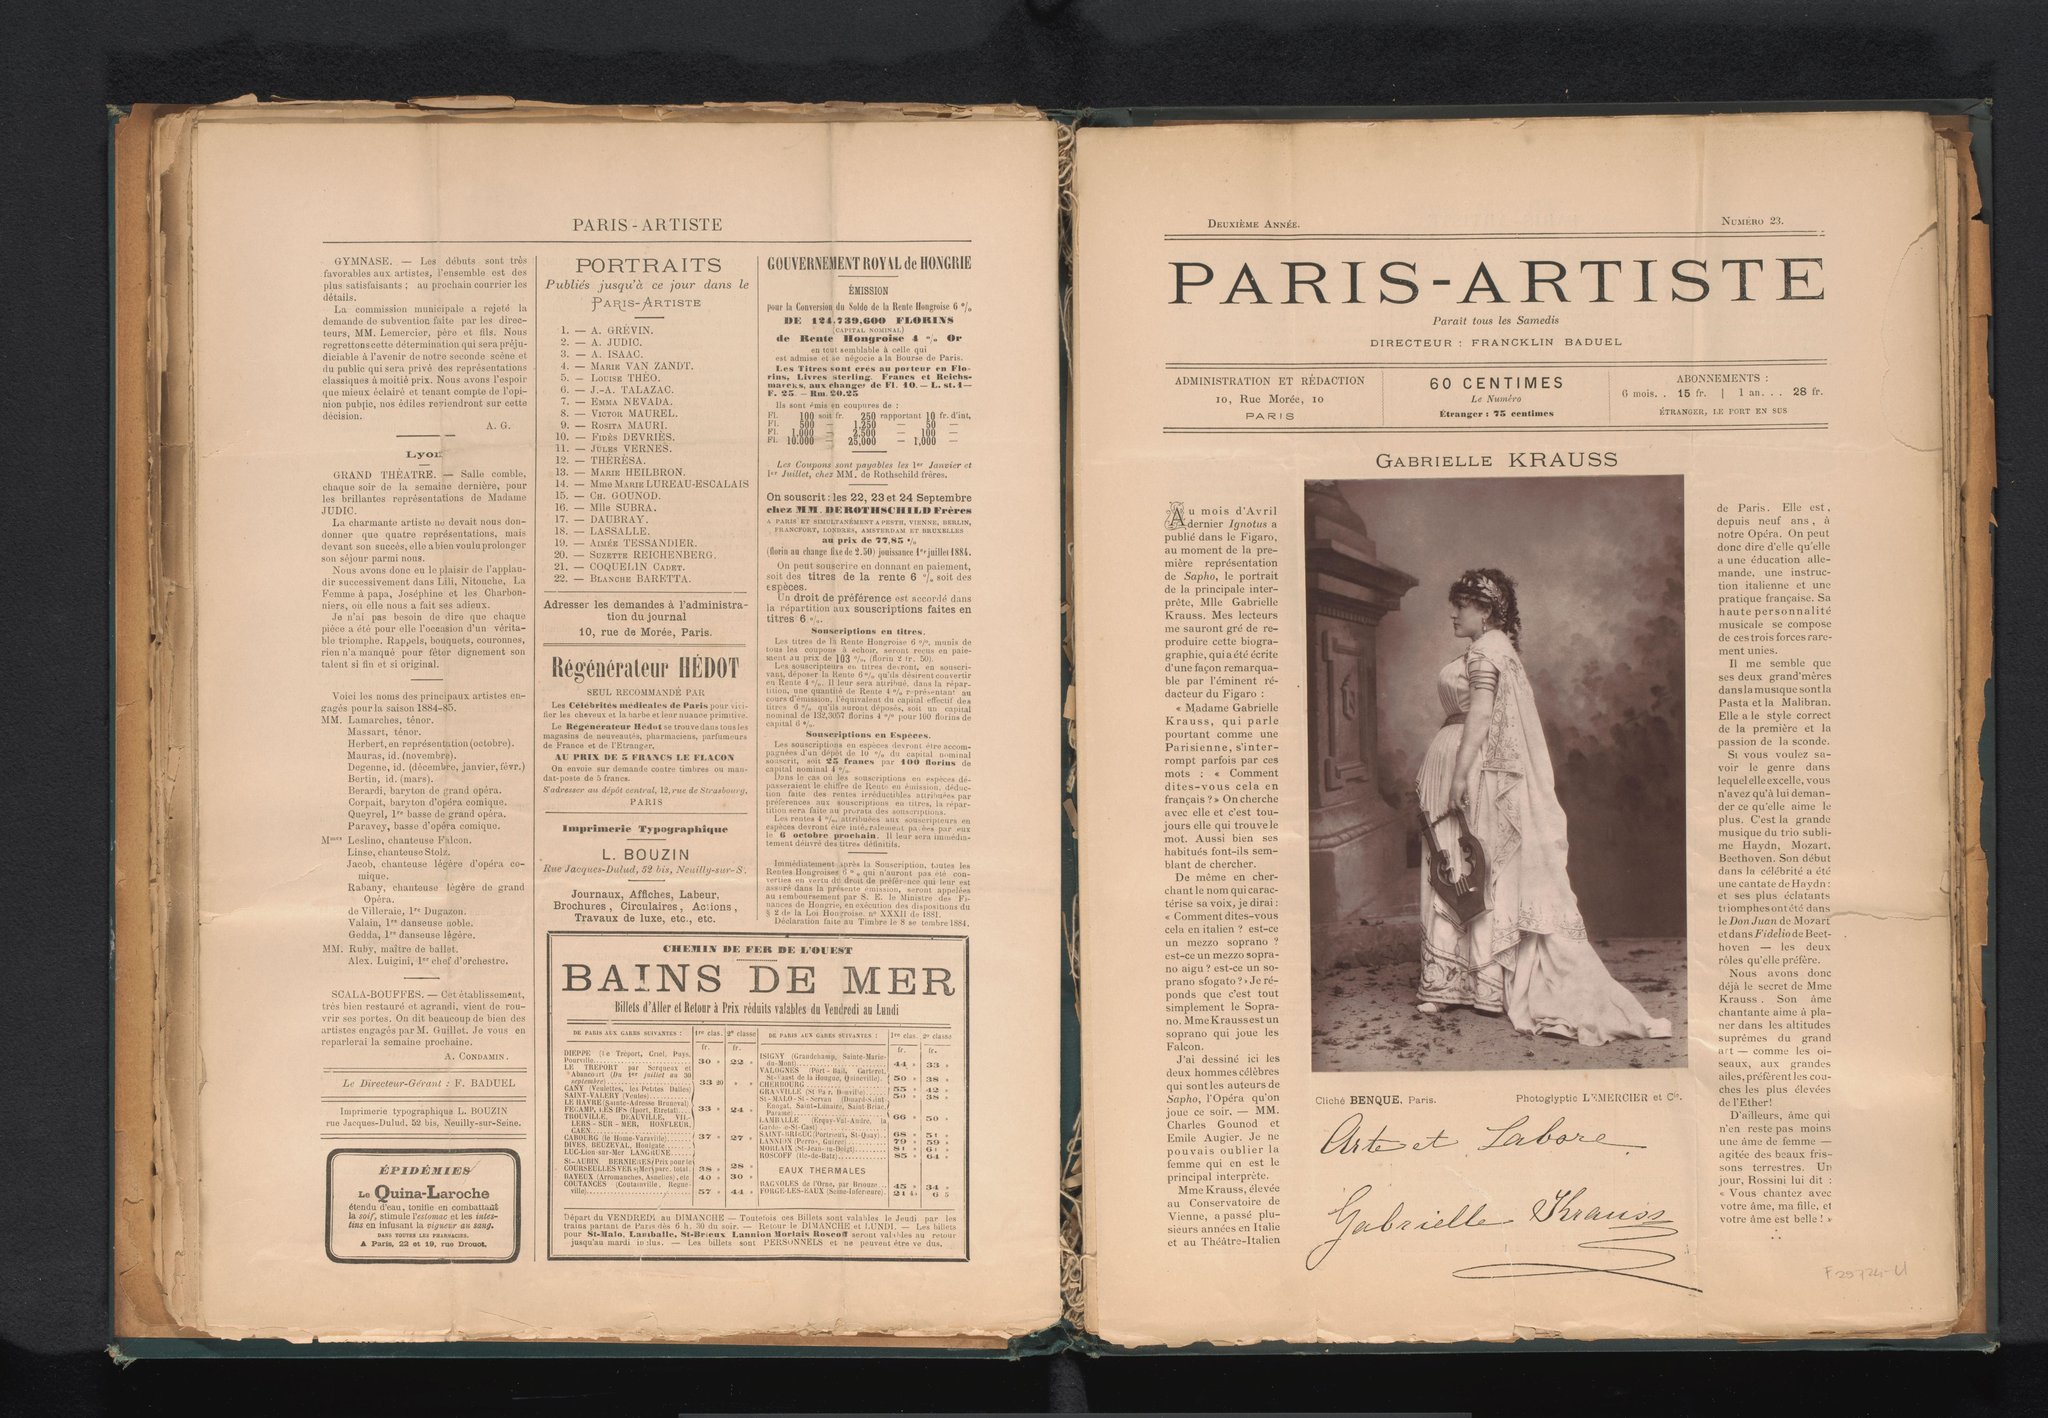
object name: page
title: Portret van Gabrielle Krauss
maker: wilhelm benque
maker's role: fotograaf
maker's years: 1843-1903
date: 1875-1884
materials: paper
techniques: woodburytype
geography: paris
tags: historical persons, opera-singer (female)